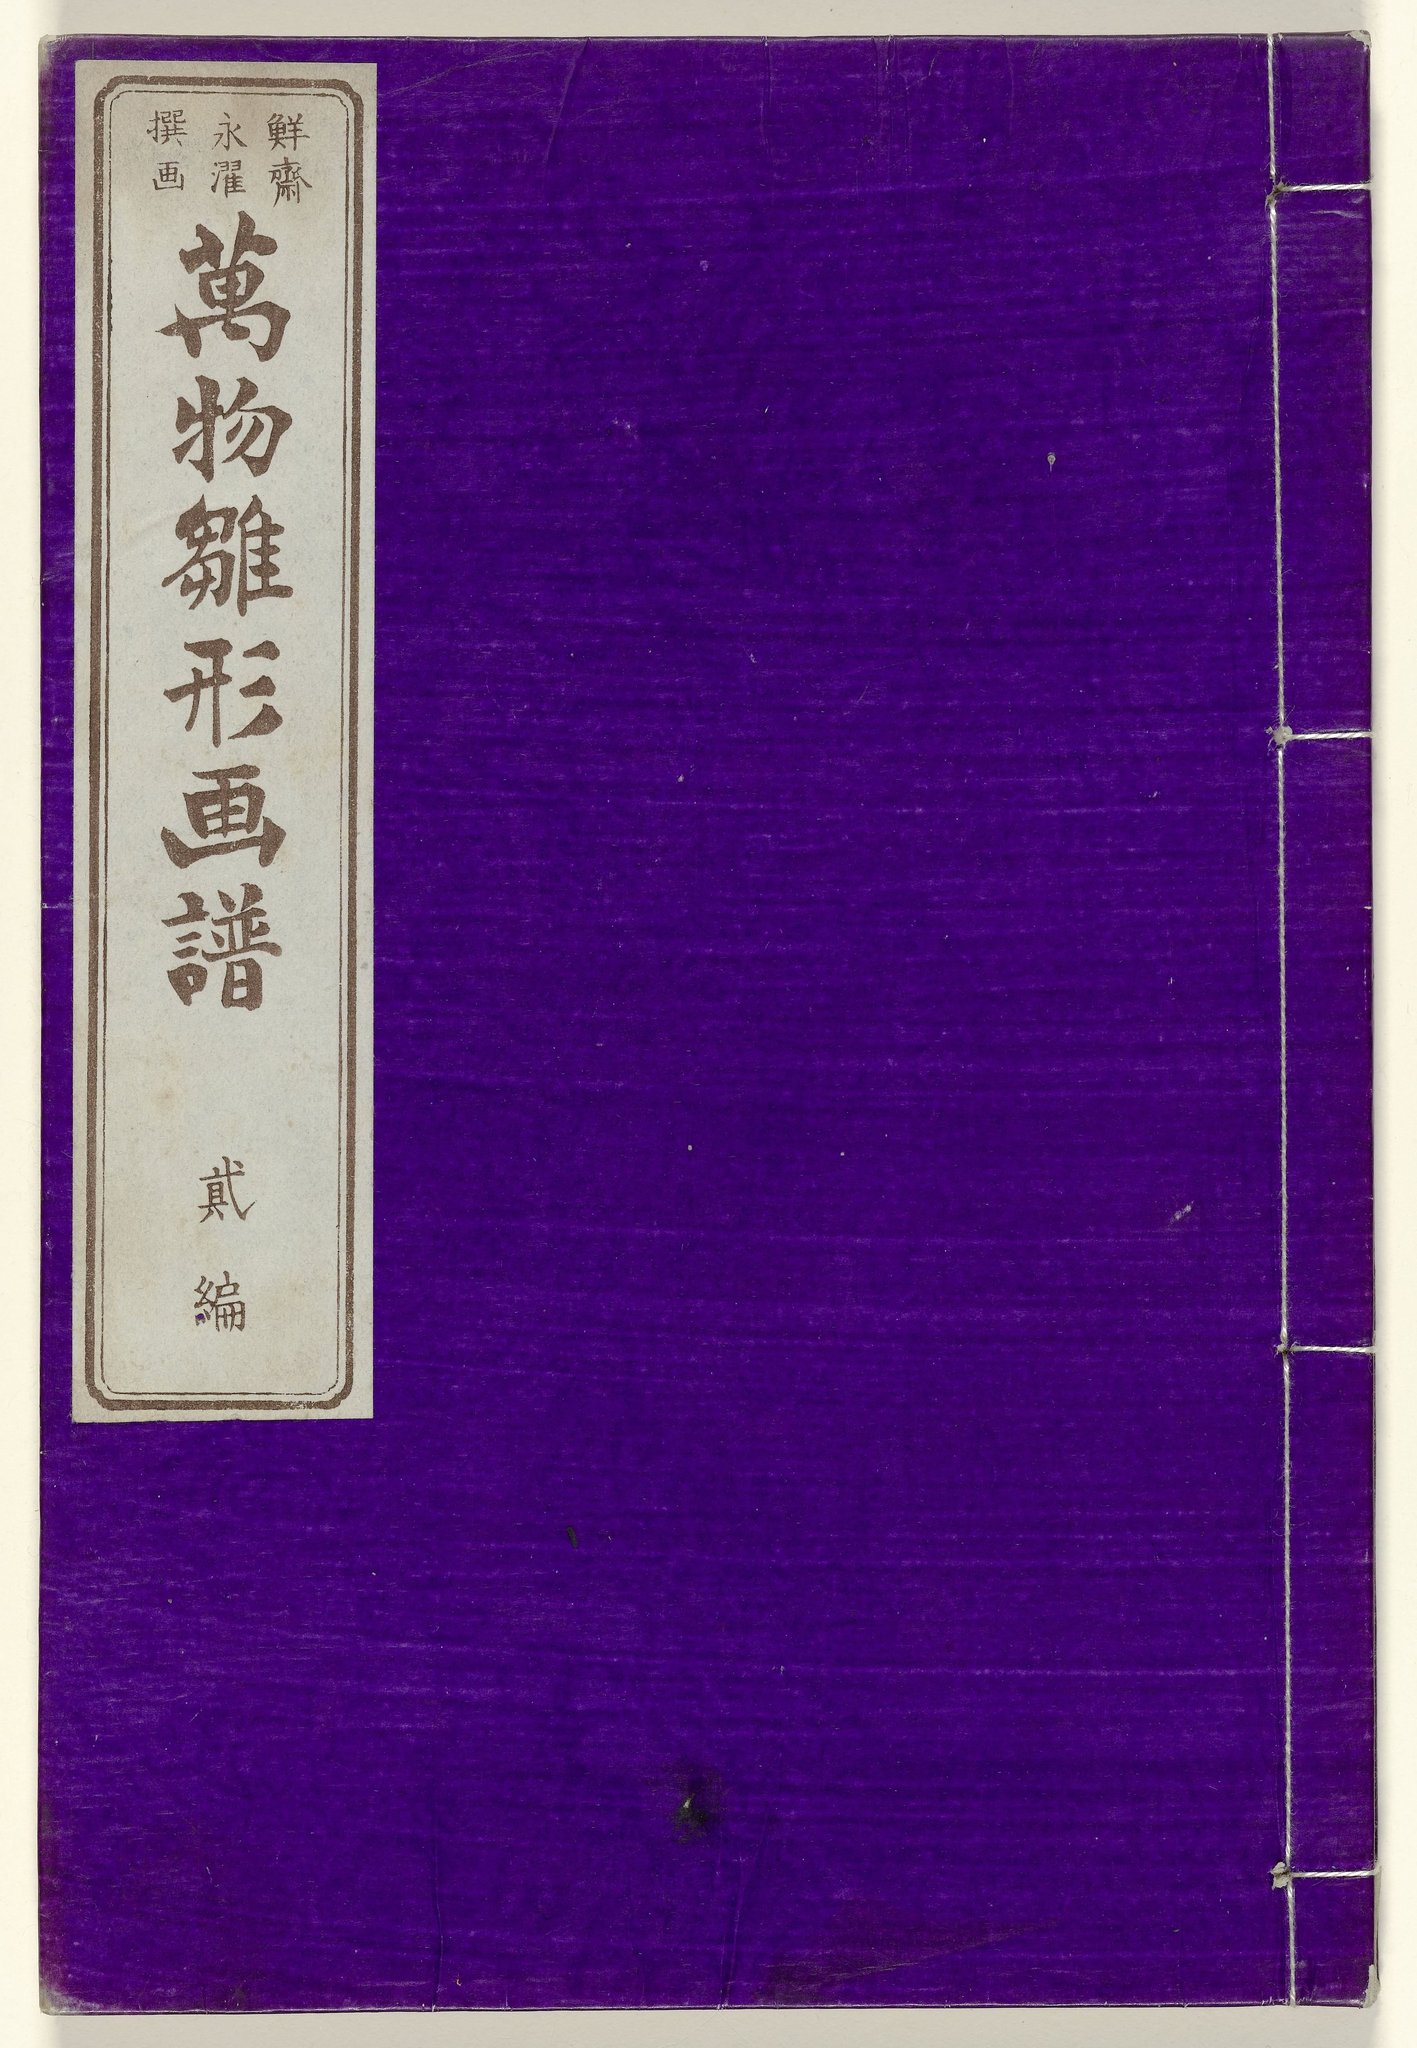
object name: book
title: Banbutsu hinagata gafu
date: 1880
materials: paper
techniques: woodcut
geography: japan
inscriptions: number: ‘467 No. 3’